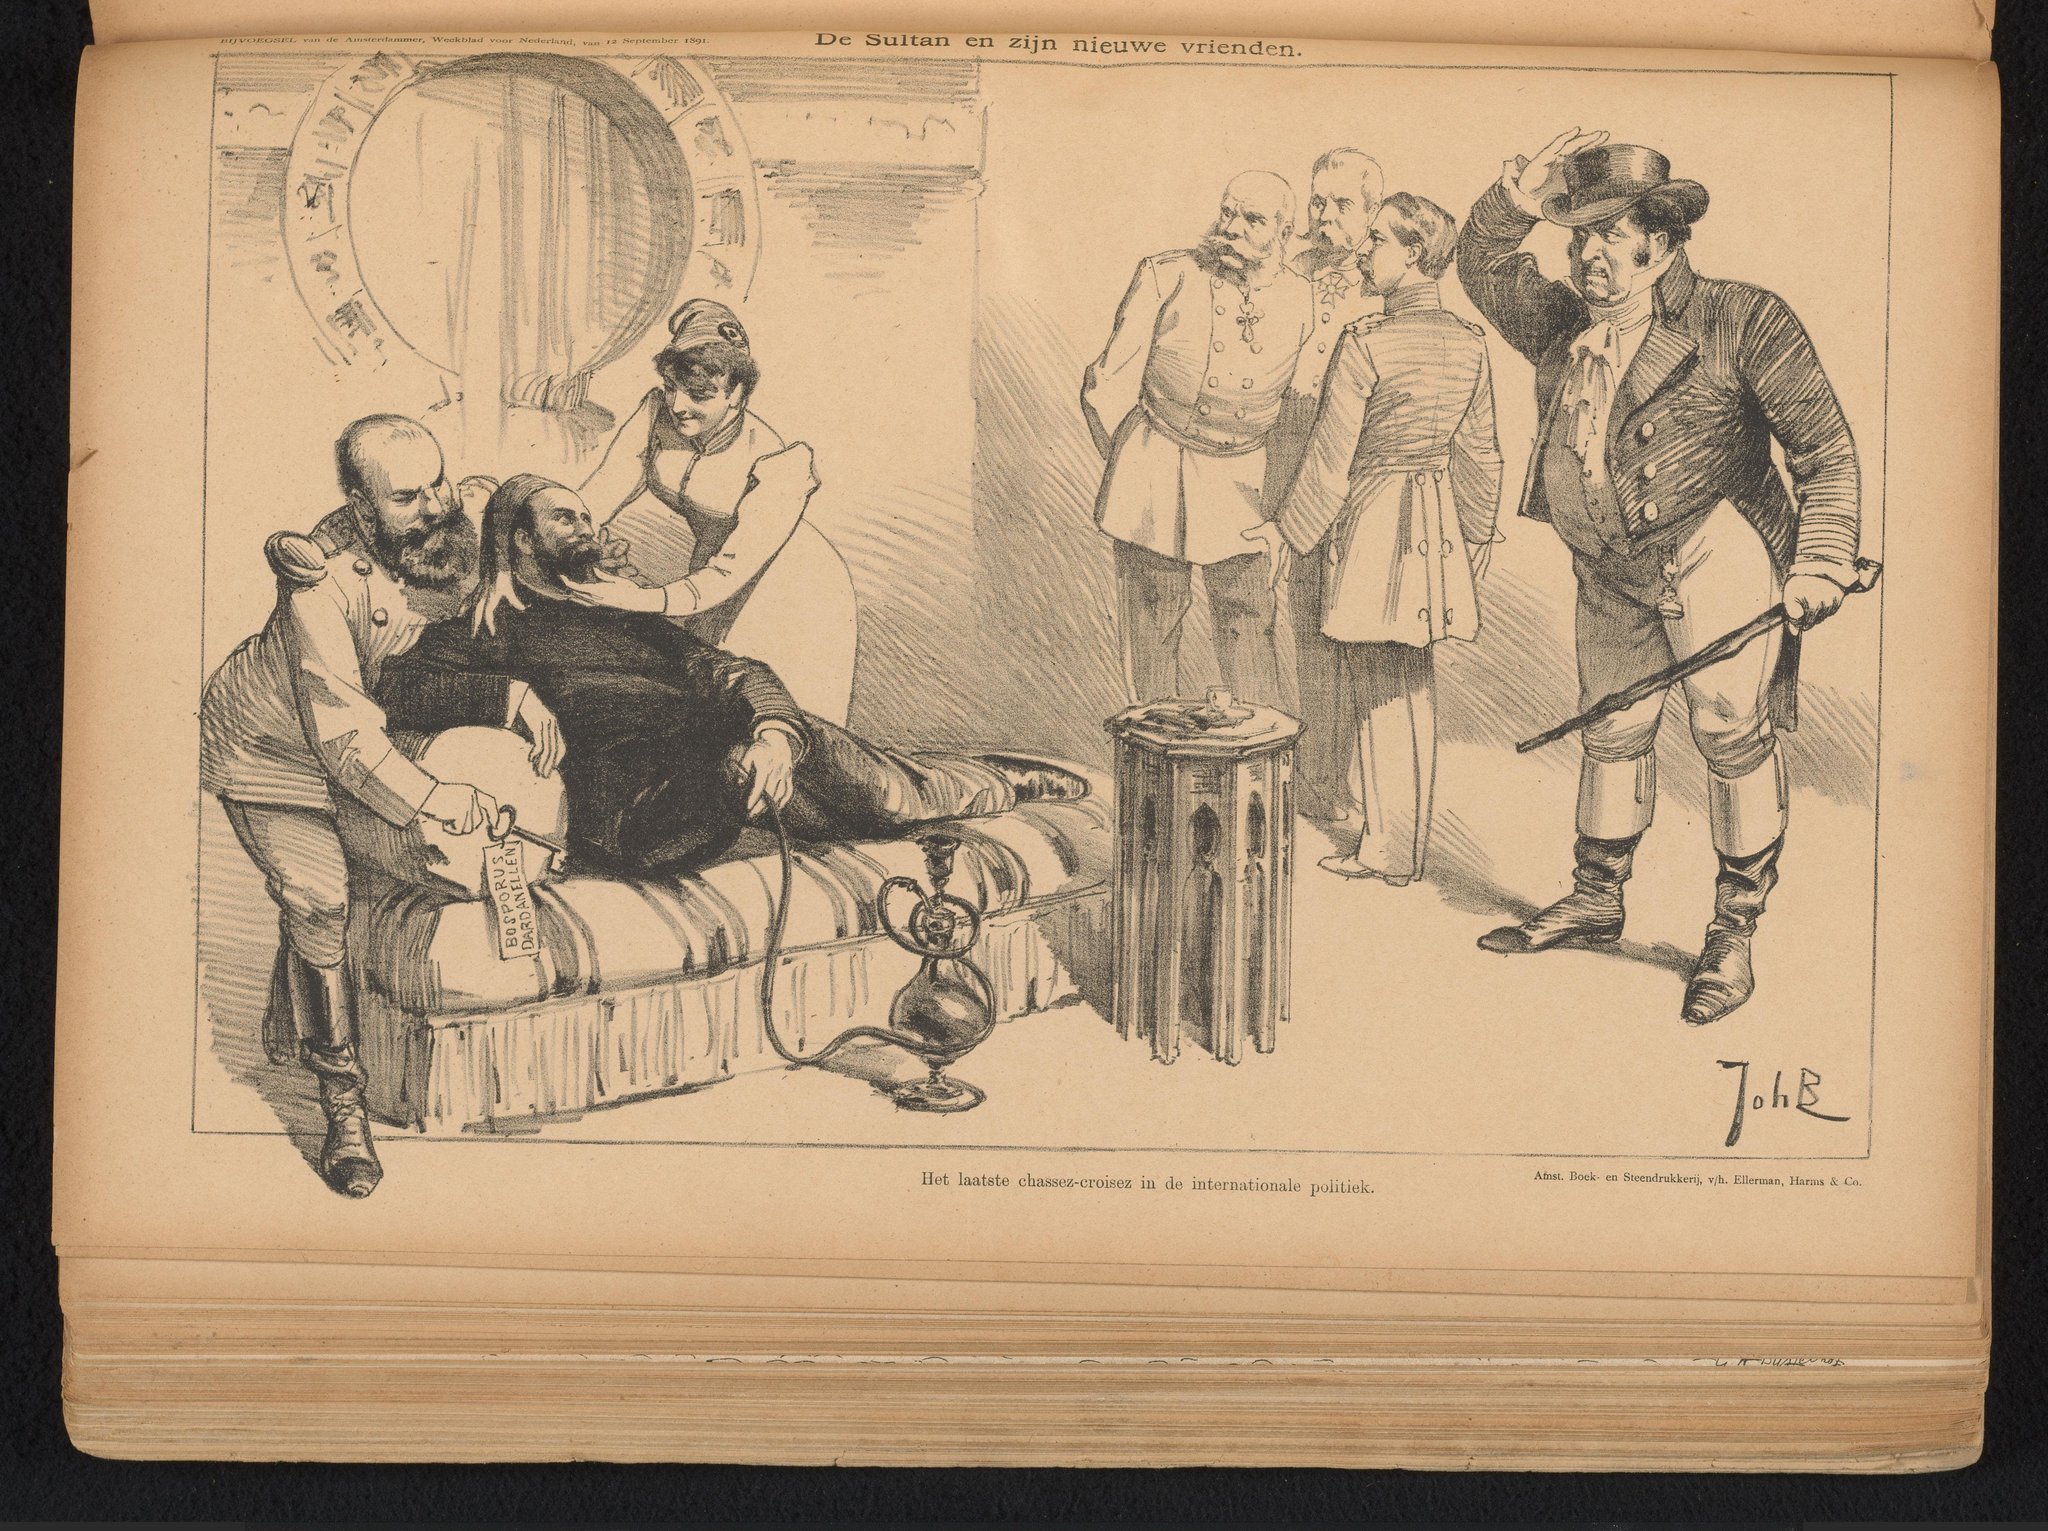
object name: cartoon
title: Vorstelijke waardeering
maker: johan braakensiek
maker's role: draughtsman, print maker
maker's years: 1858-1940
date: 1891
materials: paper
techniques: lithograph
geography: amsterdam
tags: wilhelm ii (keizer van duitsland), napoleon i (emperor of the french), banquet of elegant company (+ toast at meal, banquet), spirit, ghost, political caricatures and satires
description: De Duitse keizer Wilhelm II brengt tijdens een galadiner in Erfurt een toast uit. De schim van Napoleon luistert mee.